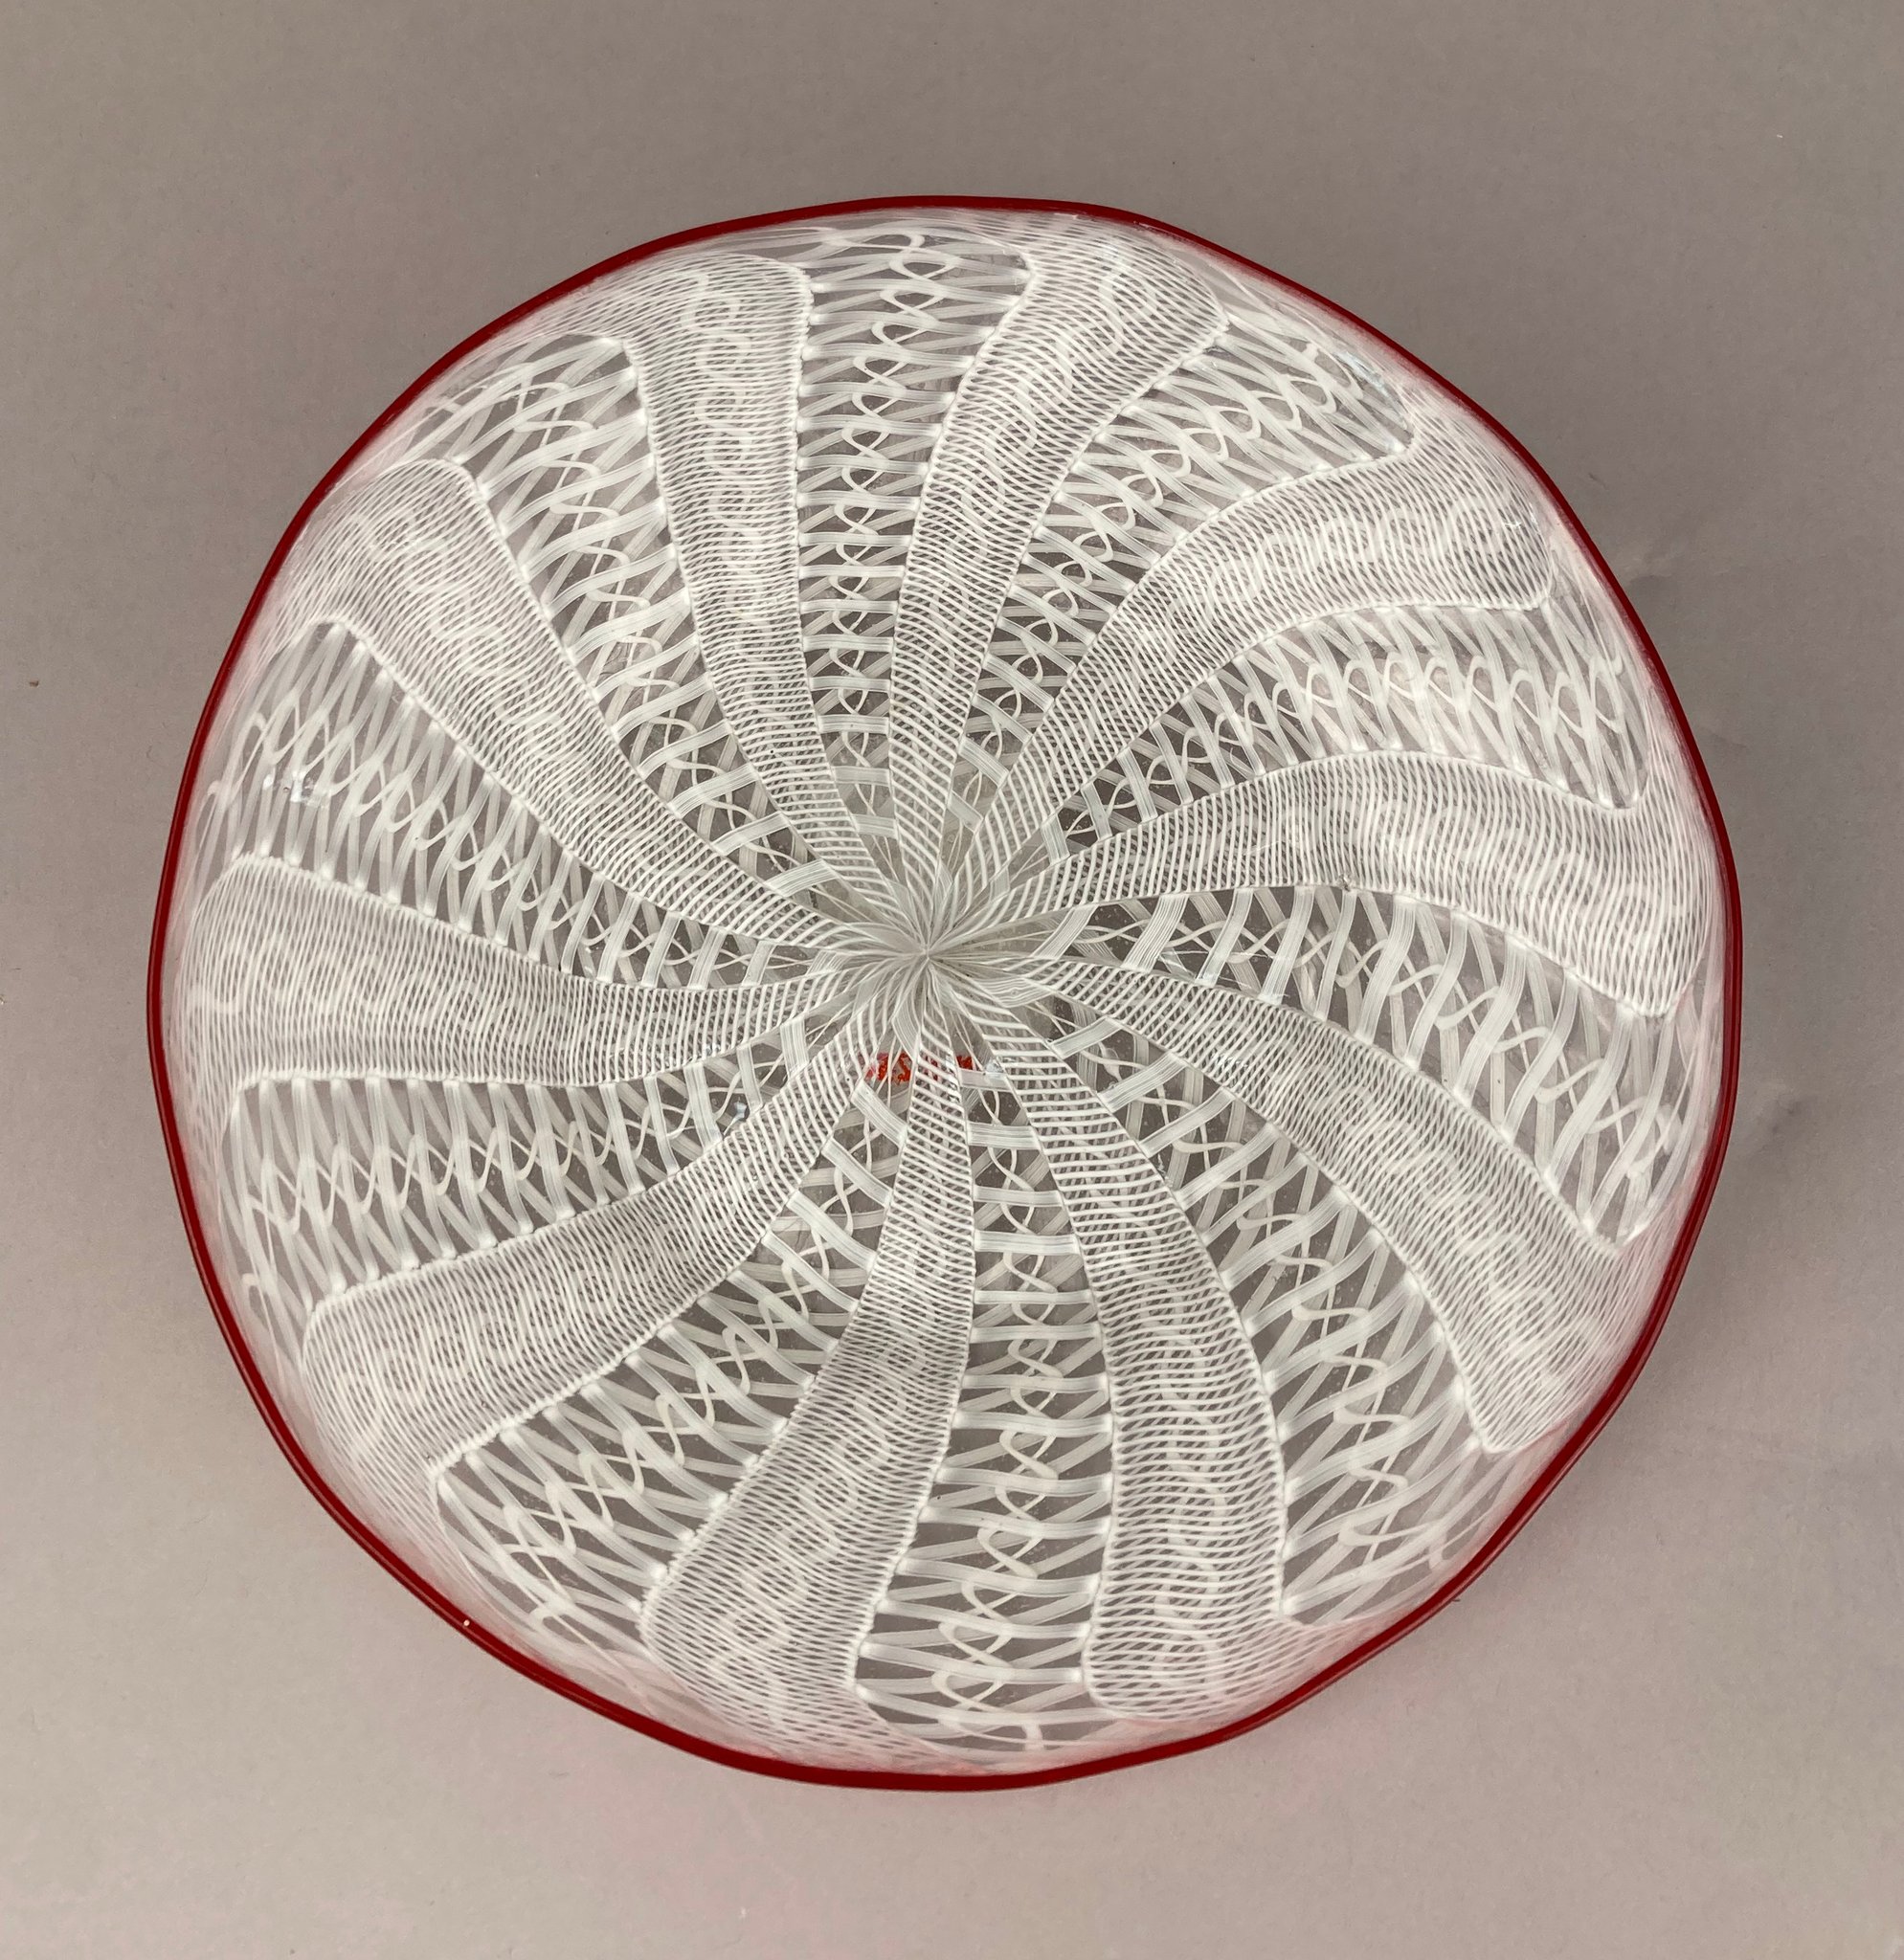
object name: dish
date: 1801-1900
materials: glass